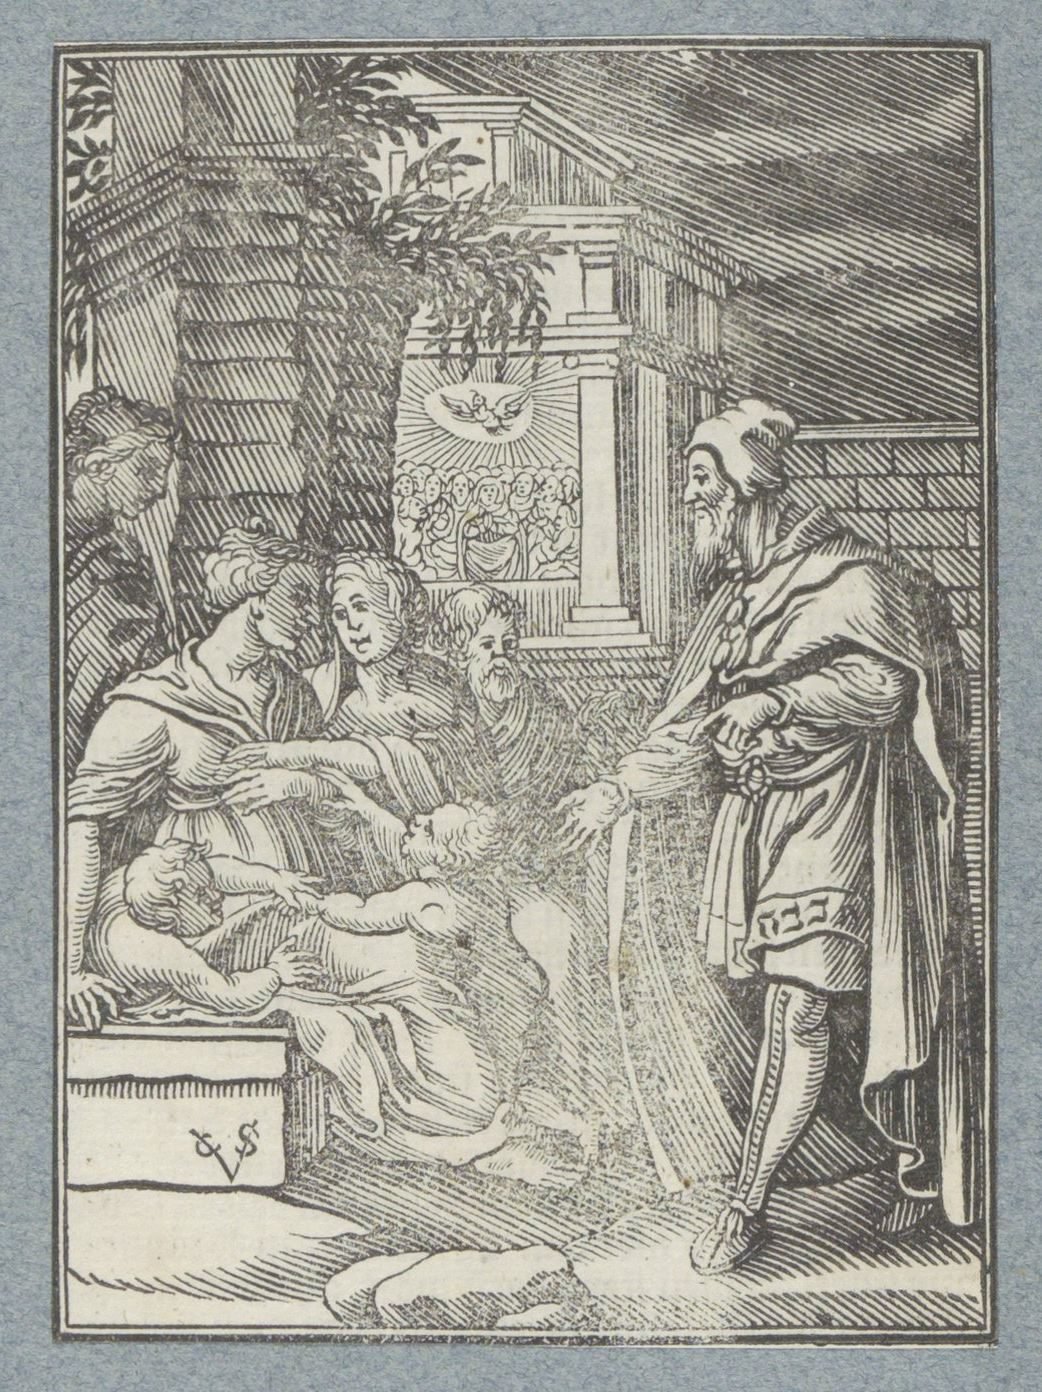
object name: print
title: Profetie van Joël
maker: pieter jacobsz. paets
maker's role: publisher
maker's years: 1587-1667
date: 1645-1646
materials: paper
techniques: woodcut, pasting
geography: amsterdam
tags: joel's prophecies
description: De profeet Joël roept zijn landgenoten op tot bekering en zich tot God te wenden, en verzekert hen van Gods bereidheid hen te vergeven. Op de achtergrond de uitstorting van de Heilige Geest als verbeelding van: 'Ik zal mijn geest uitgieten over al wat leeft' (Joël 2:28). De prent maakt deel uit van een album.